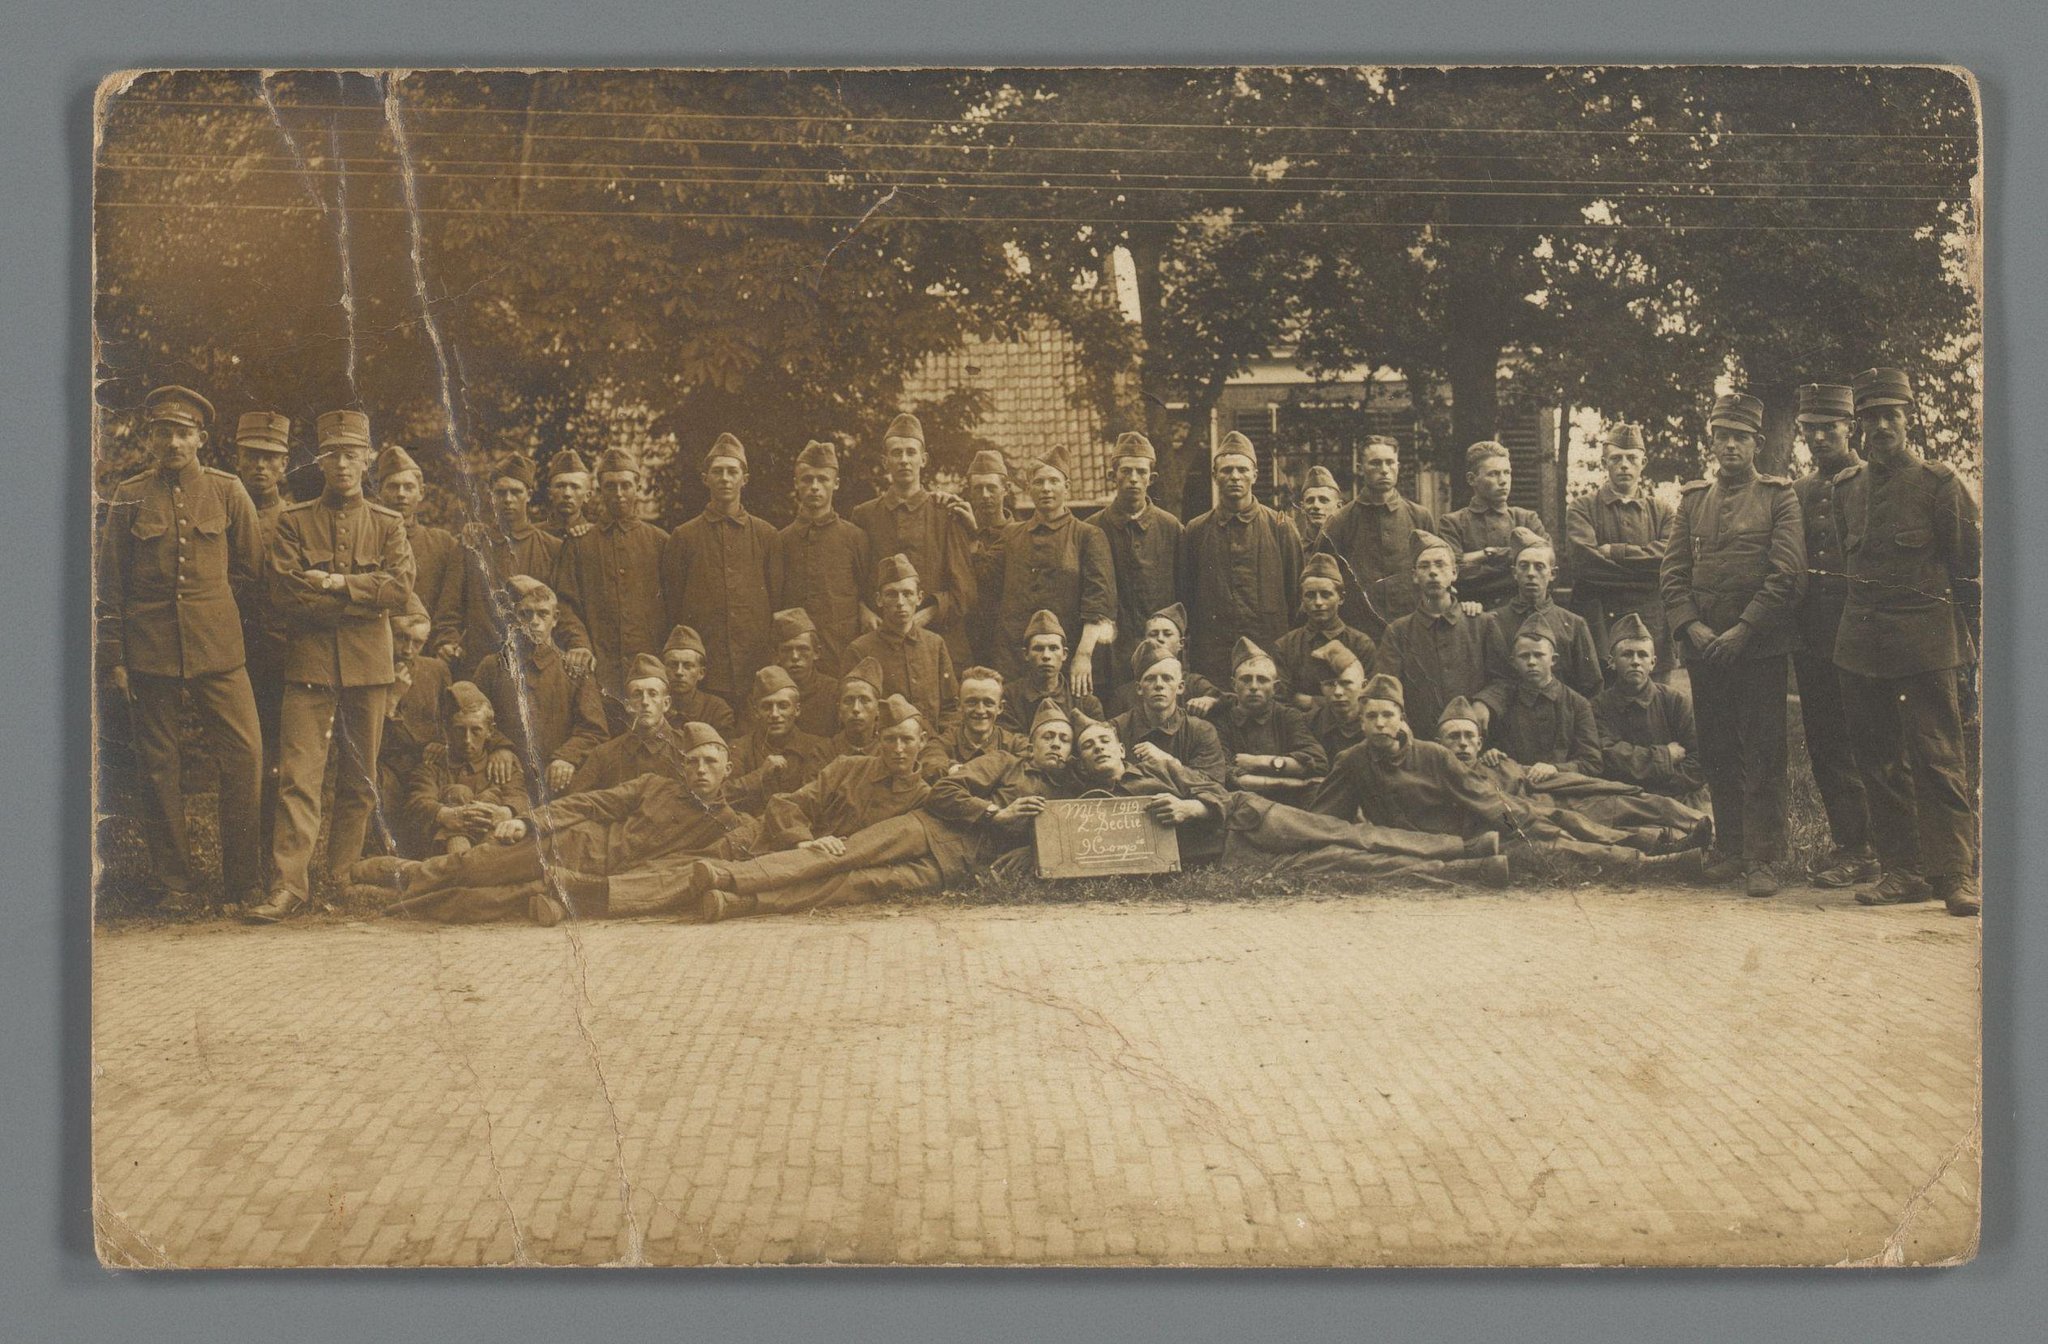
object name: photograph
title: Groepsportret van onbekende militairen van de negende compagnie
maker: Anonymous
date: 1919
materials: paper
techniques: gelatin silver print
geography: netherlands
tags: the company, the unit, the troop ~ military service, anonymous historical persons portrayed in a group, in a group-portrait, netherlands